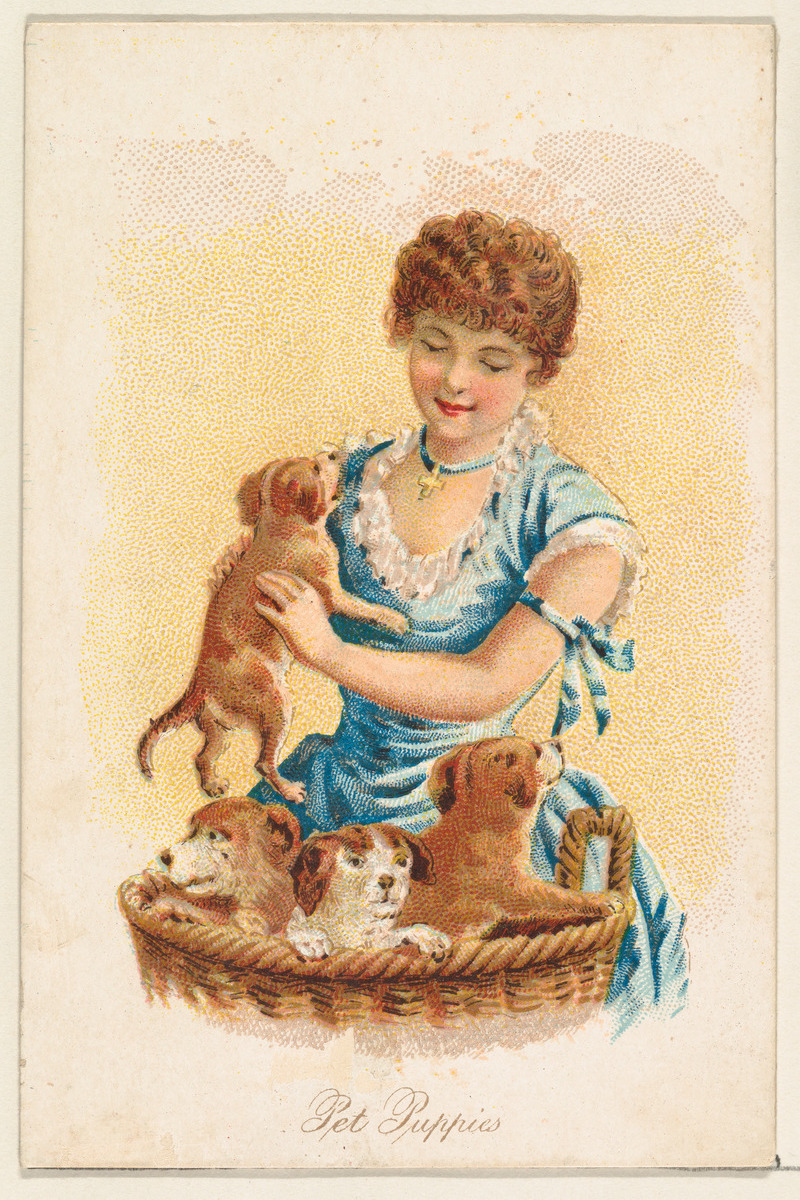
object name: print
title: Pet Puppies, from the Household Pets series (N194) issued by Wm. S. Kimball & Co.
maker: william s. kimball & company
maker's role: publisher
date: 1891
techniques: color lithograph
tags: love,women,dogs